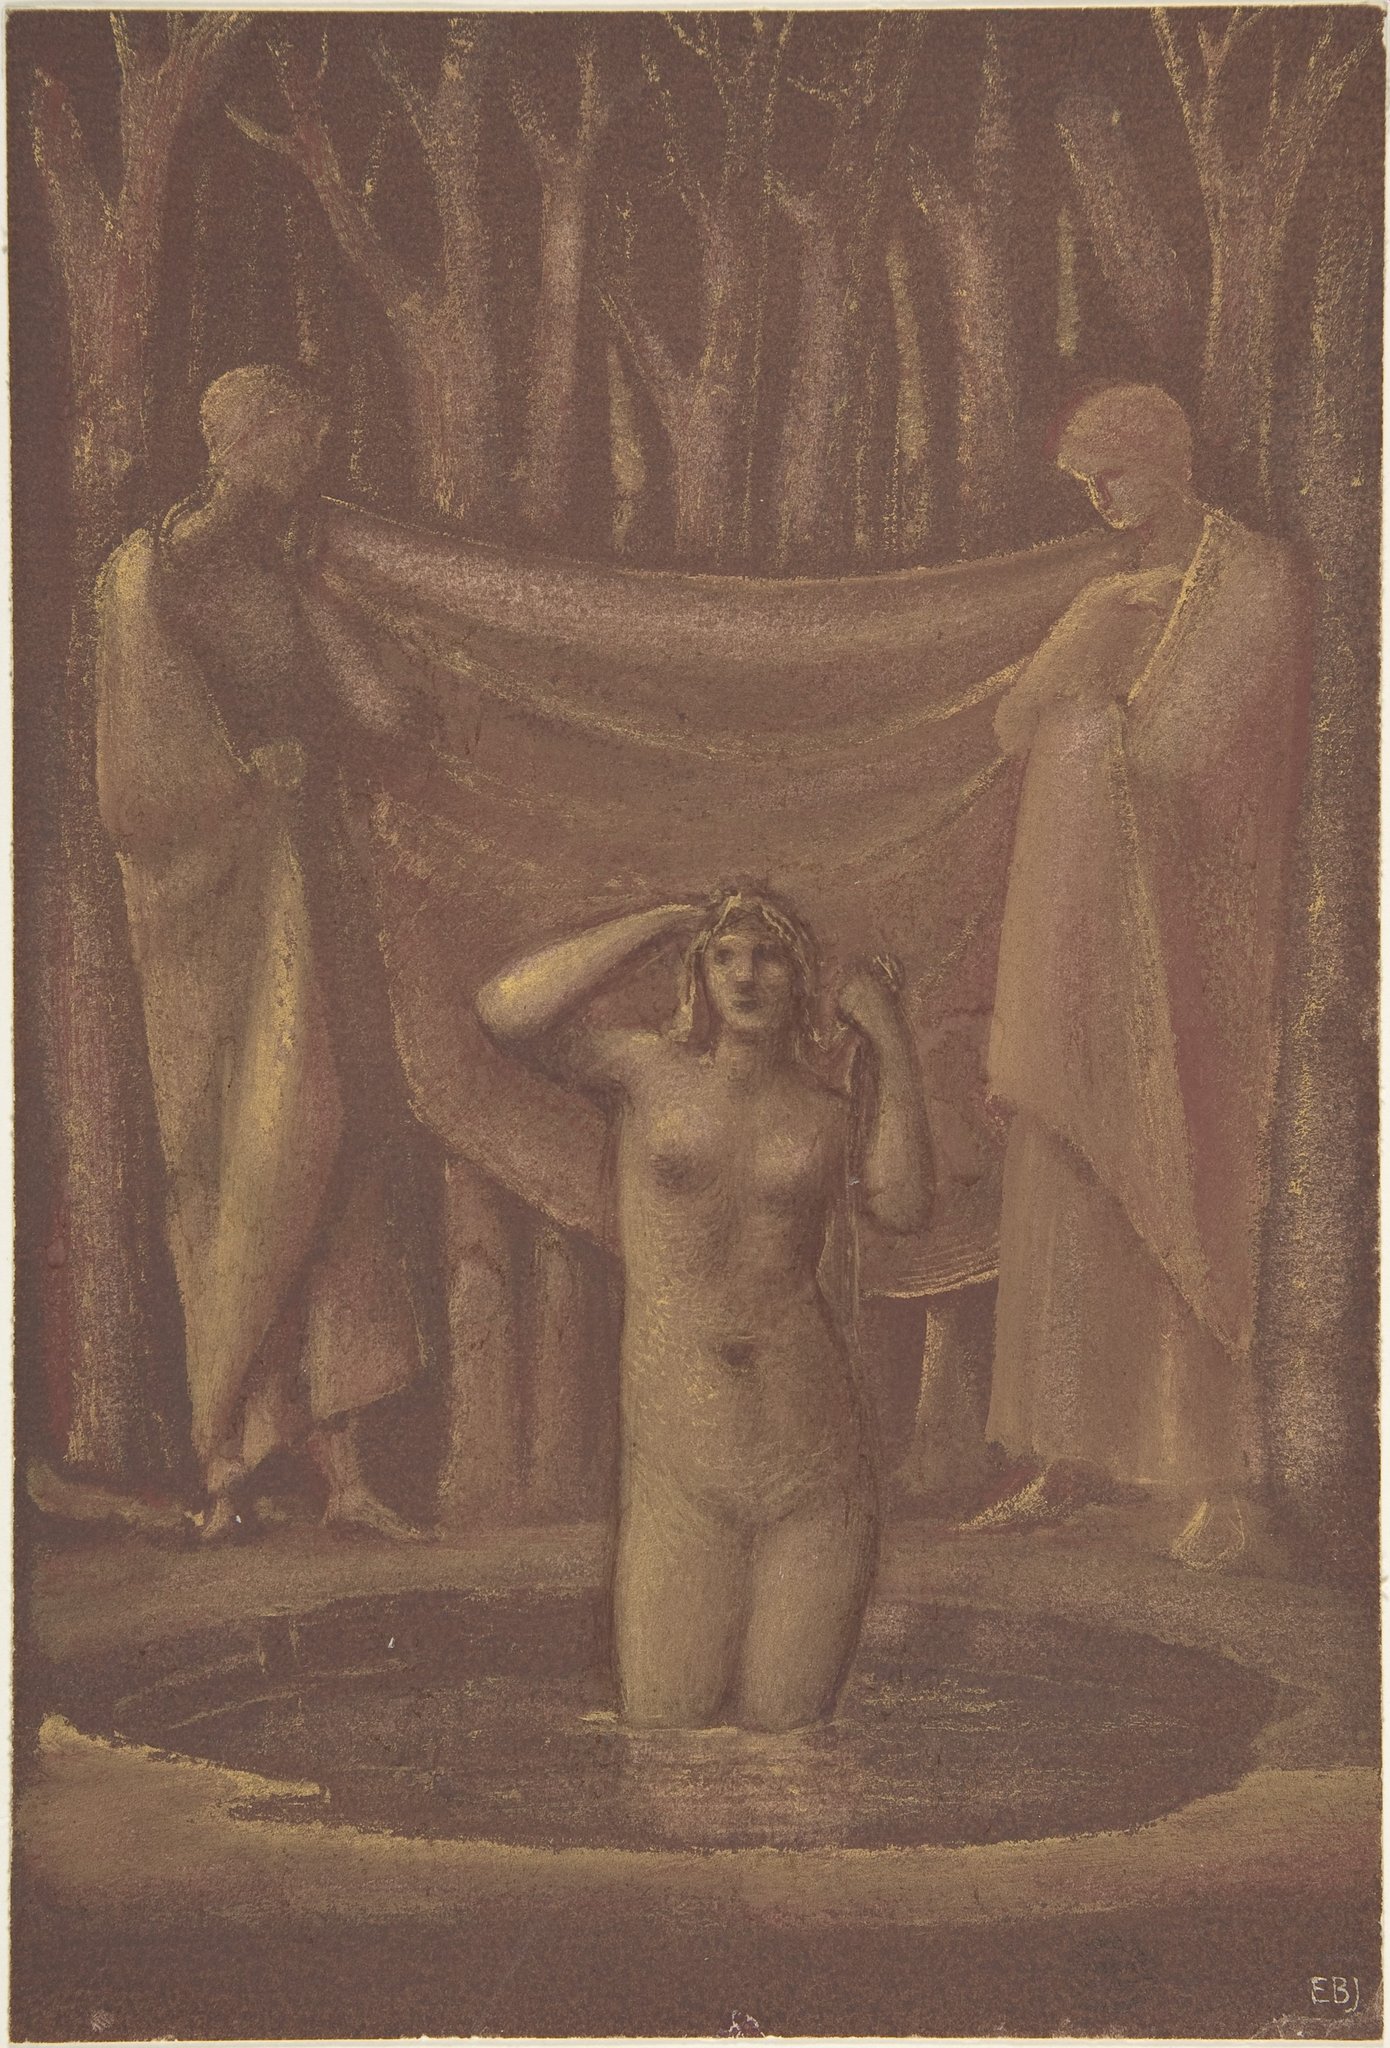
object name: drawing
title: Bath of Venus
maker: sir edward burne-jones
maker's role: artist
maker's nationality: british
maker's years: 1833-1898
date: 1890-1899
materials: graphite, paint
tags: human figures,venus,bathing